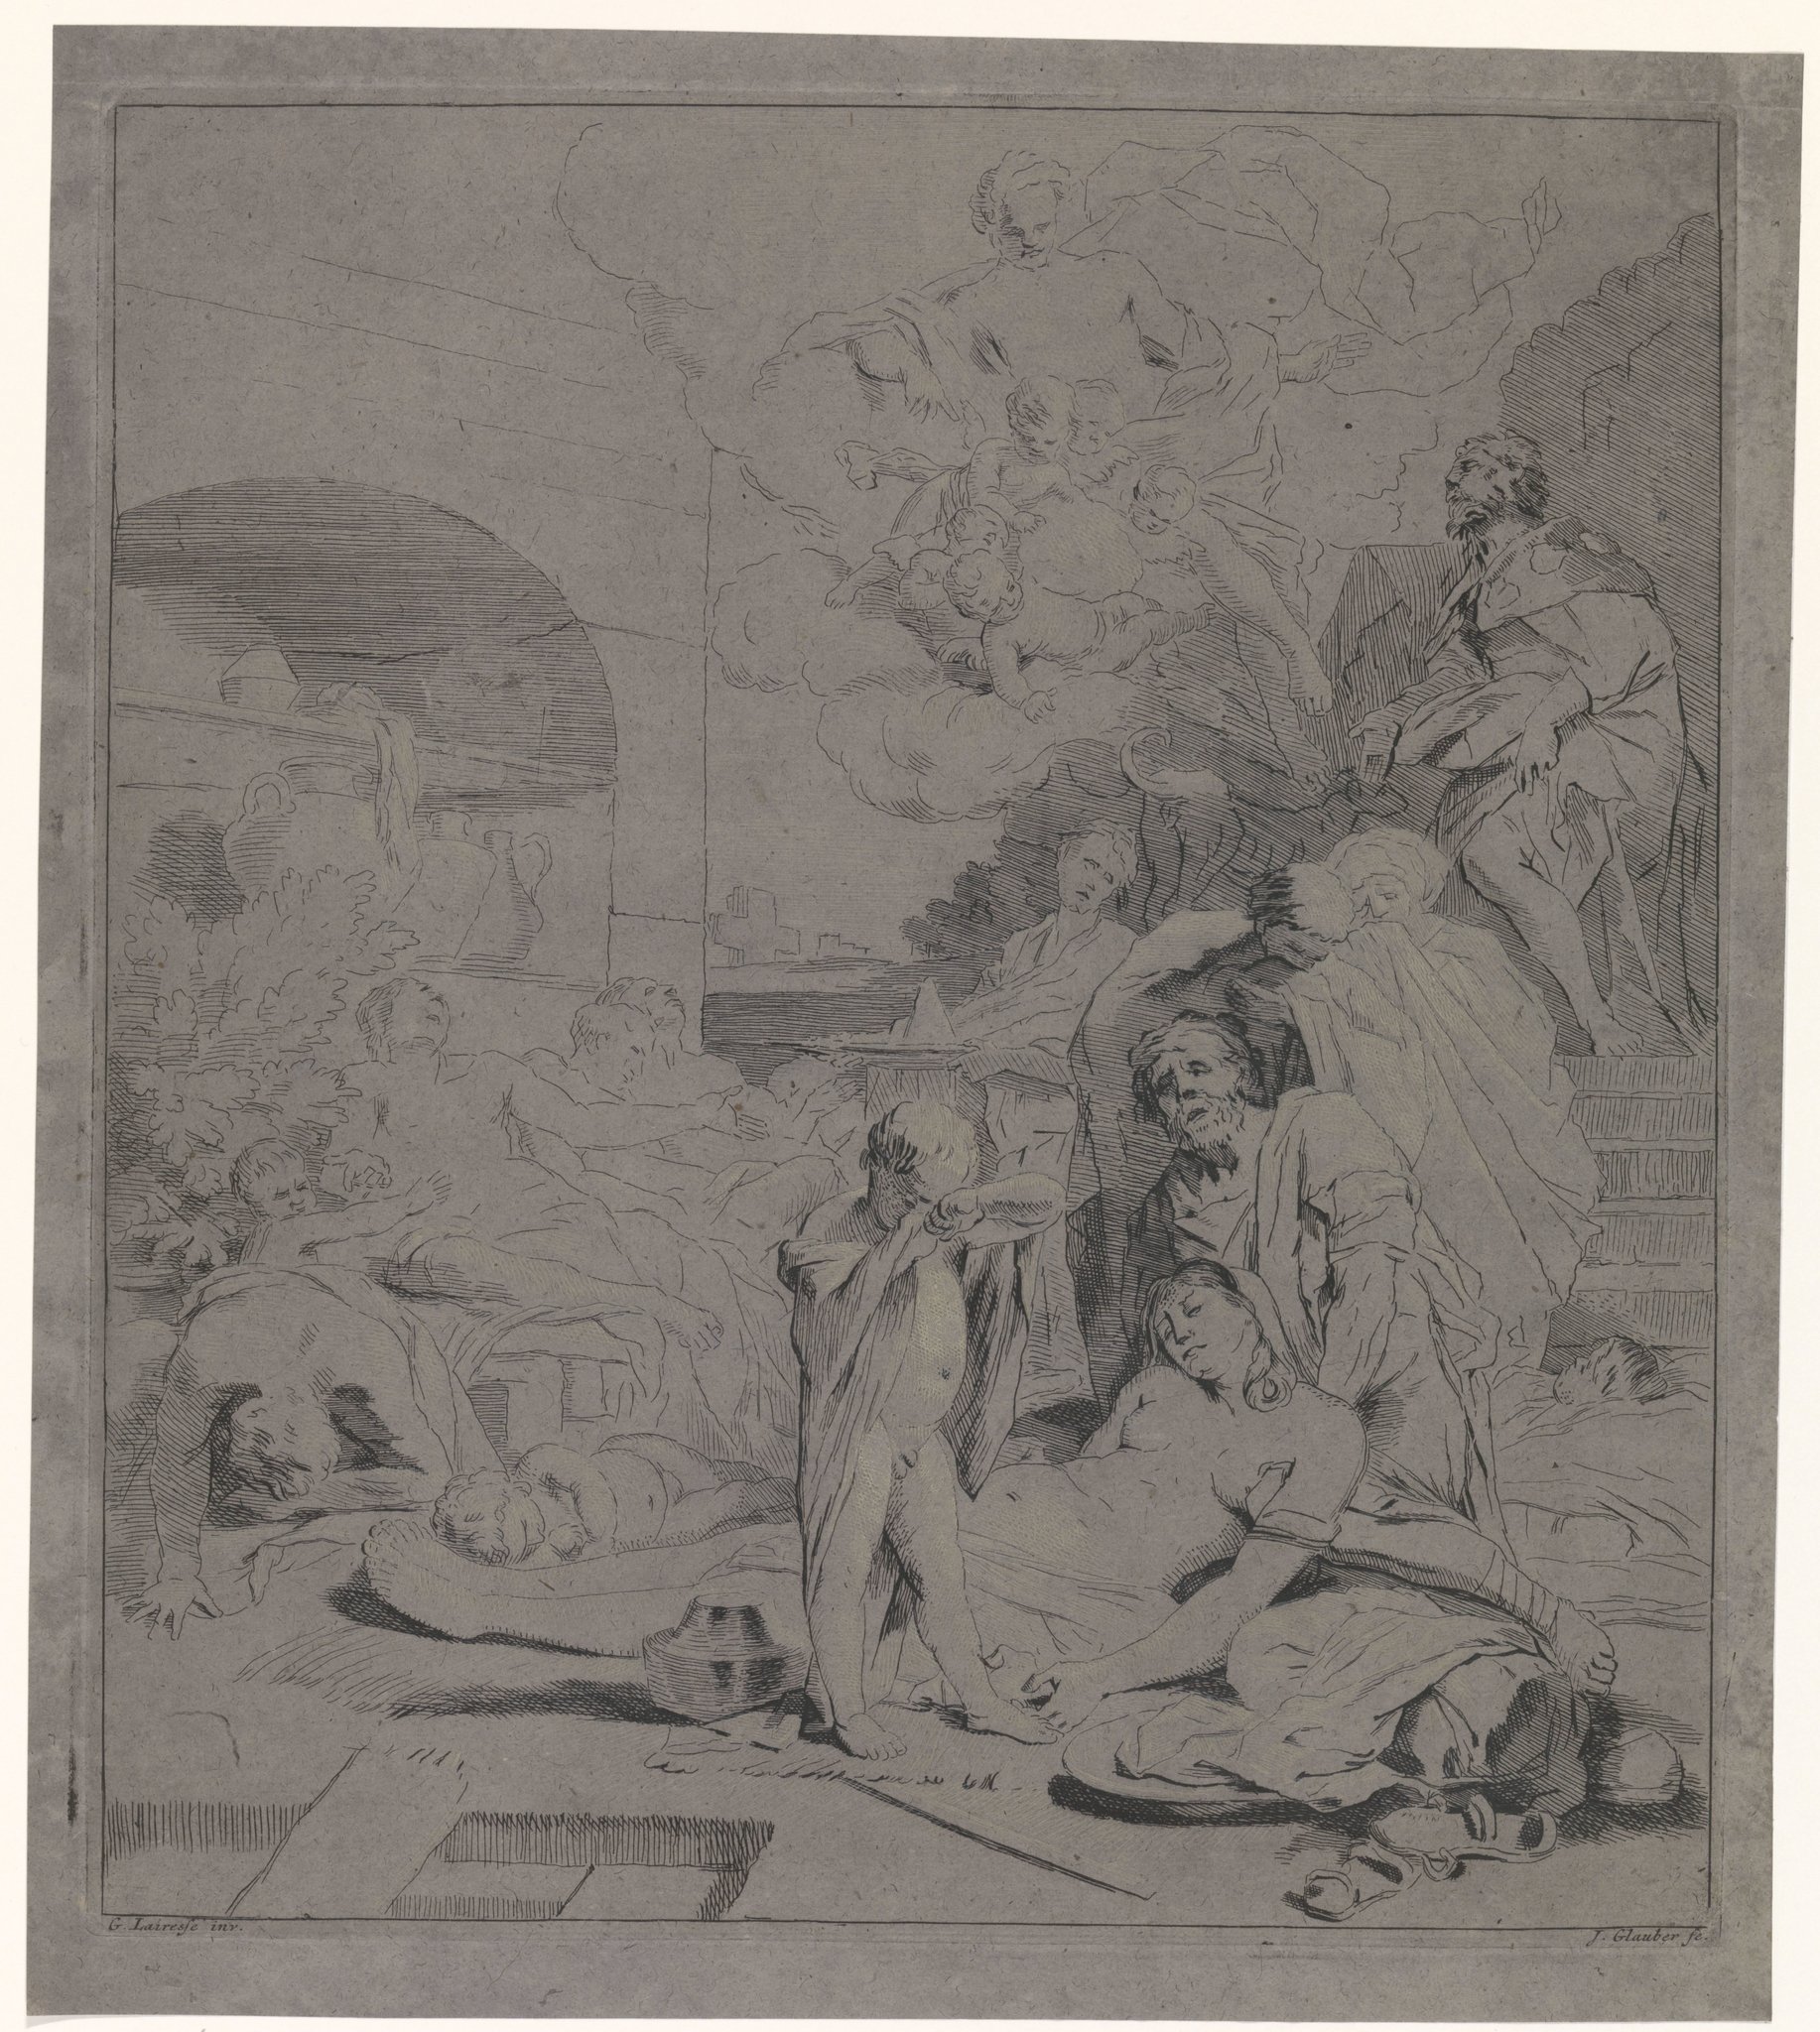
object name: print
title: Smeekbede van de heilige Rochus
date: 1656-1726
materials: paper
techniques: etching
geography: amsterdam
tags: cupids: 'amores', 'amoretti', 'putti', st. roch interceding with mary for the plague-stricken (+ mary)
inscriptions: collector's mark: Lugt 240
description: Tijdens een uitbraak van de pest smeekt de heilige Rochus (rechts boven) de maagd Maria om hulp. Op de voorgrond een groep pestlijders. De prent maakt deel uit van een serie met Bijbelse, mythologische en allegorische voorstellingen.